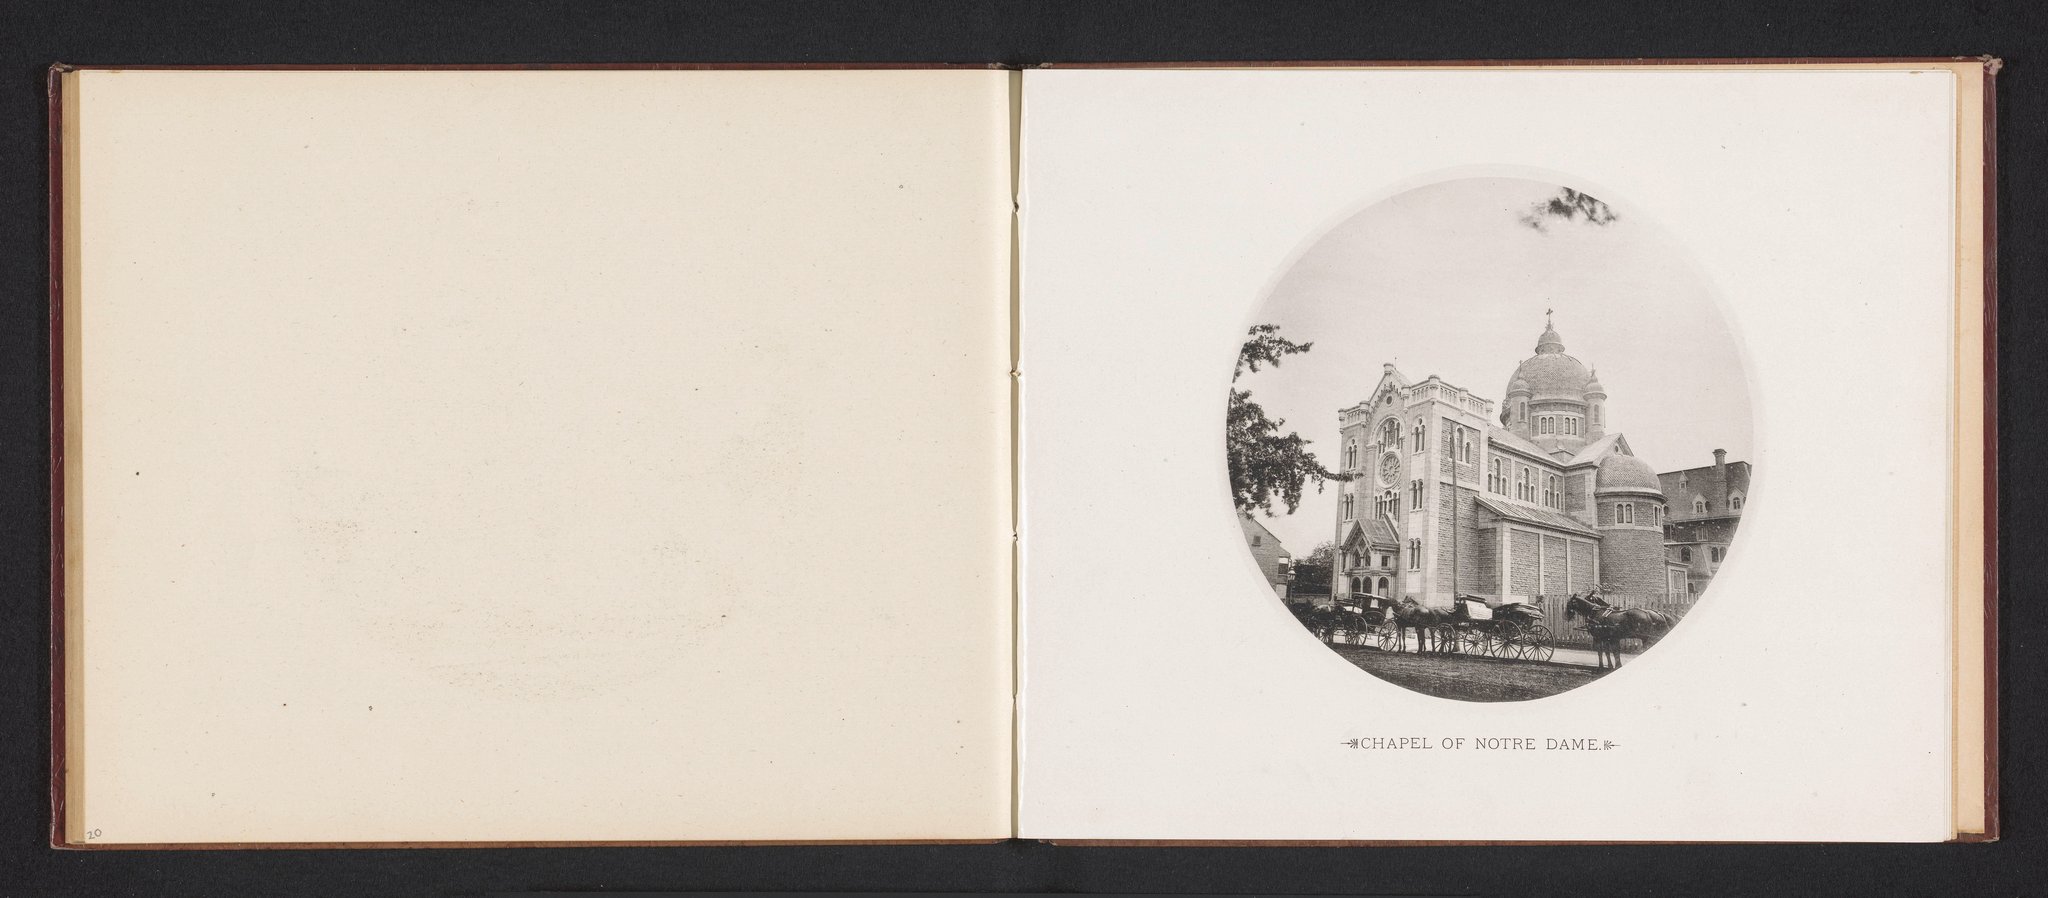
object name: photomechanical print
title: Chapel of Notre Dame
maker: Anonymous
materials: paper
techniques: photograph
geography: montreal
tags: parts of church exterior and annexes: chapel